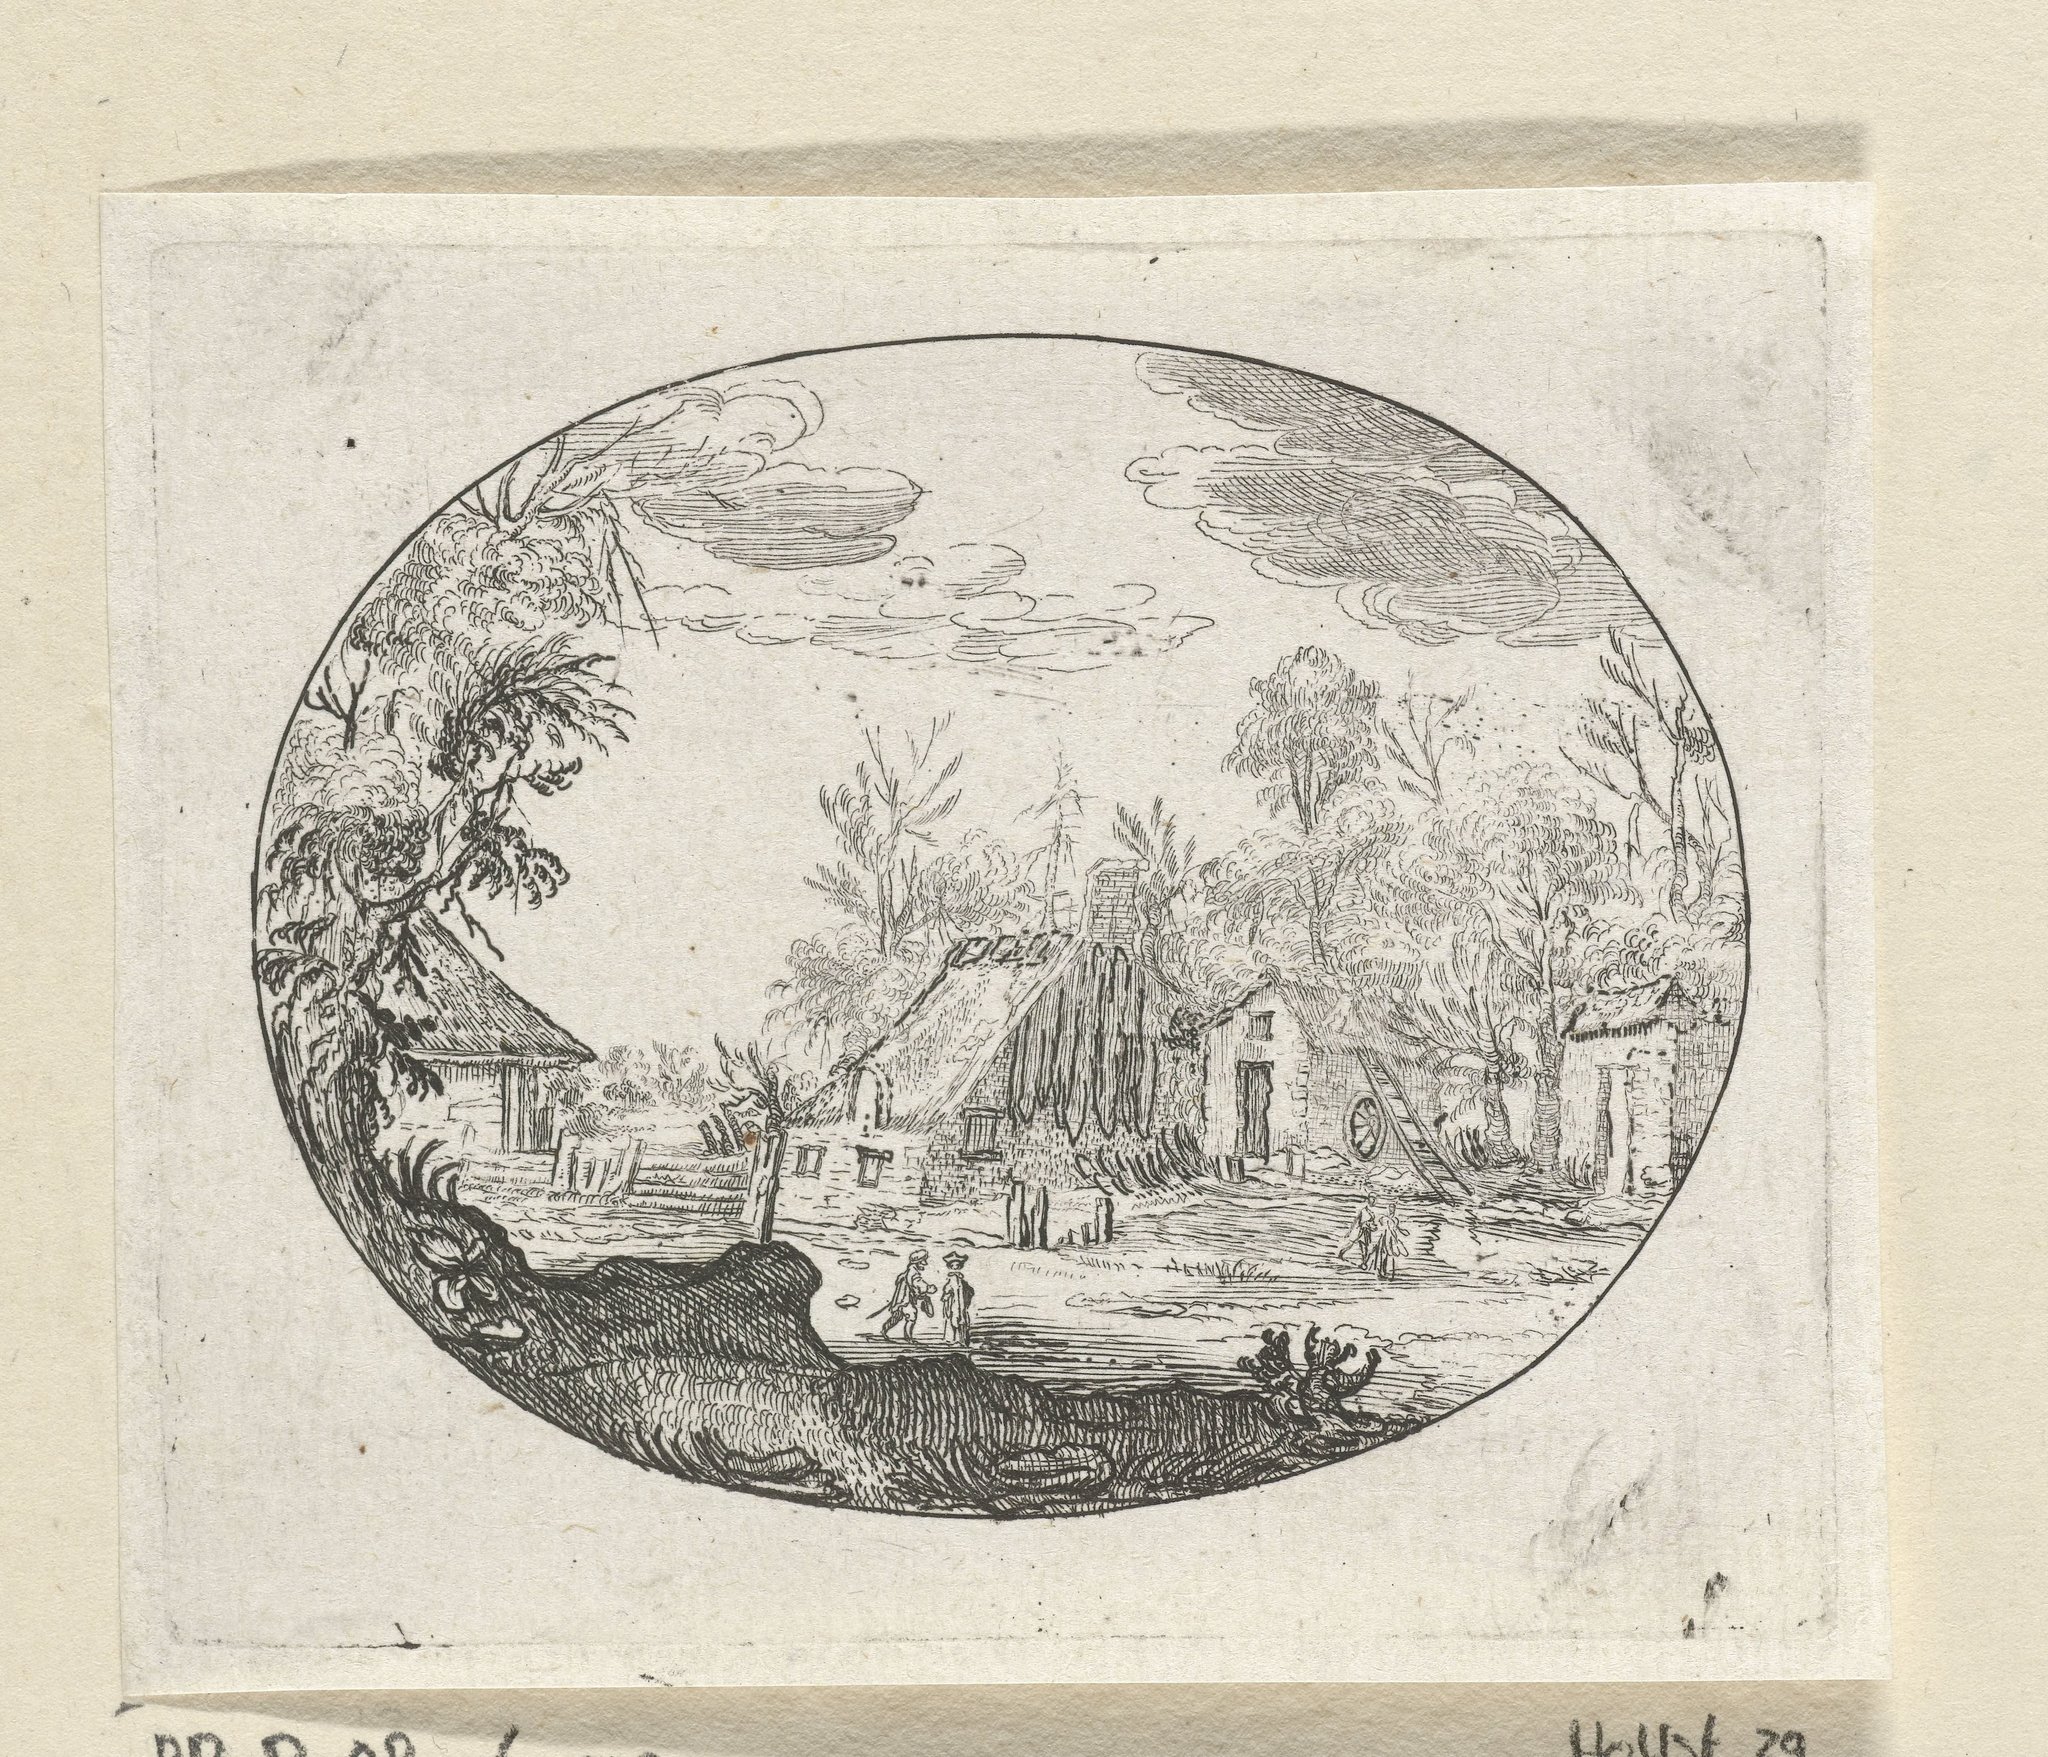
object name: print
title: Figuren bij een boerderij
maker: chaerles de hooch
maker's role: painter, print maker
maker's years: 1600-1638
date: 1613-1638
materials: paper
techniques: engraving, etching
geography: northern netherlands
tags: landscapes (+ landscape with figures, staffage), farm or solitary house in landscape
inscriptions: collector's mark: Lugt 240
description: Een landschap met figuren bij een boerderij. Prent uit een serie van acht met voorstellingen van landschappen, alle in een ovaal.